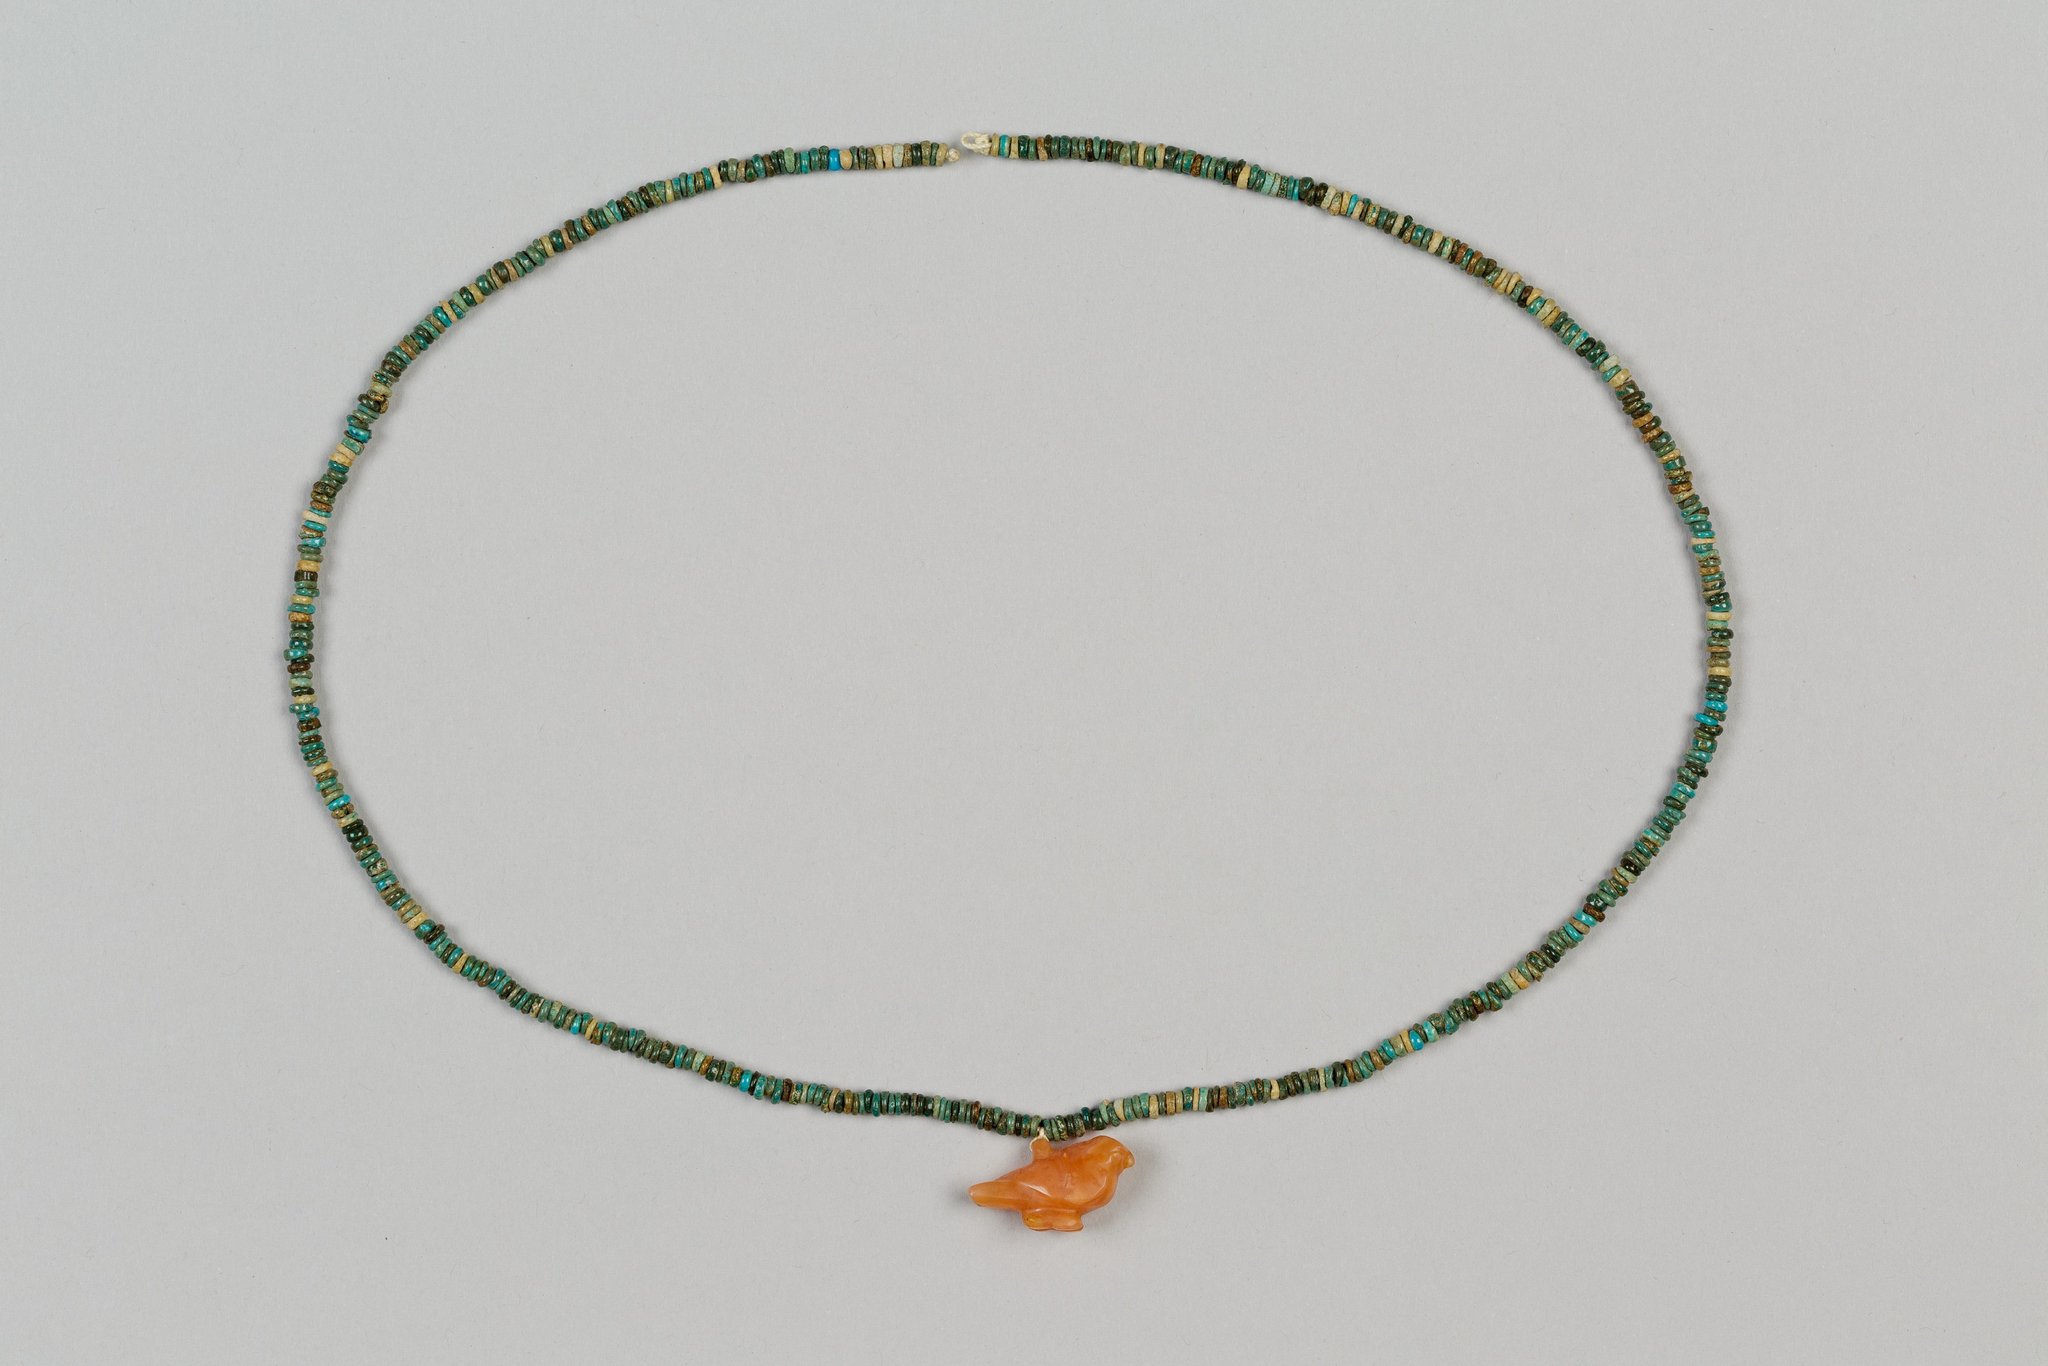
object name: string of disk bead, senebtisi, falcon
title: String of disk beads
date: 1850-1775 BCE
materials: faience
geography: egypt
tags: birds